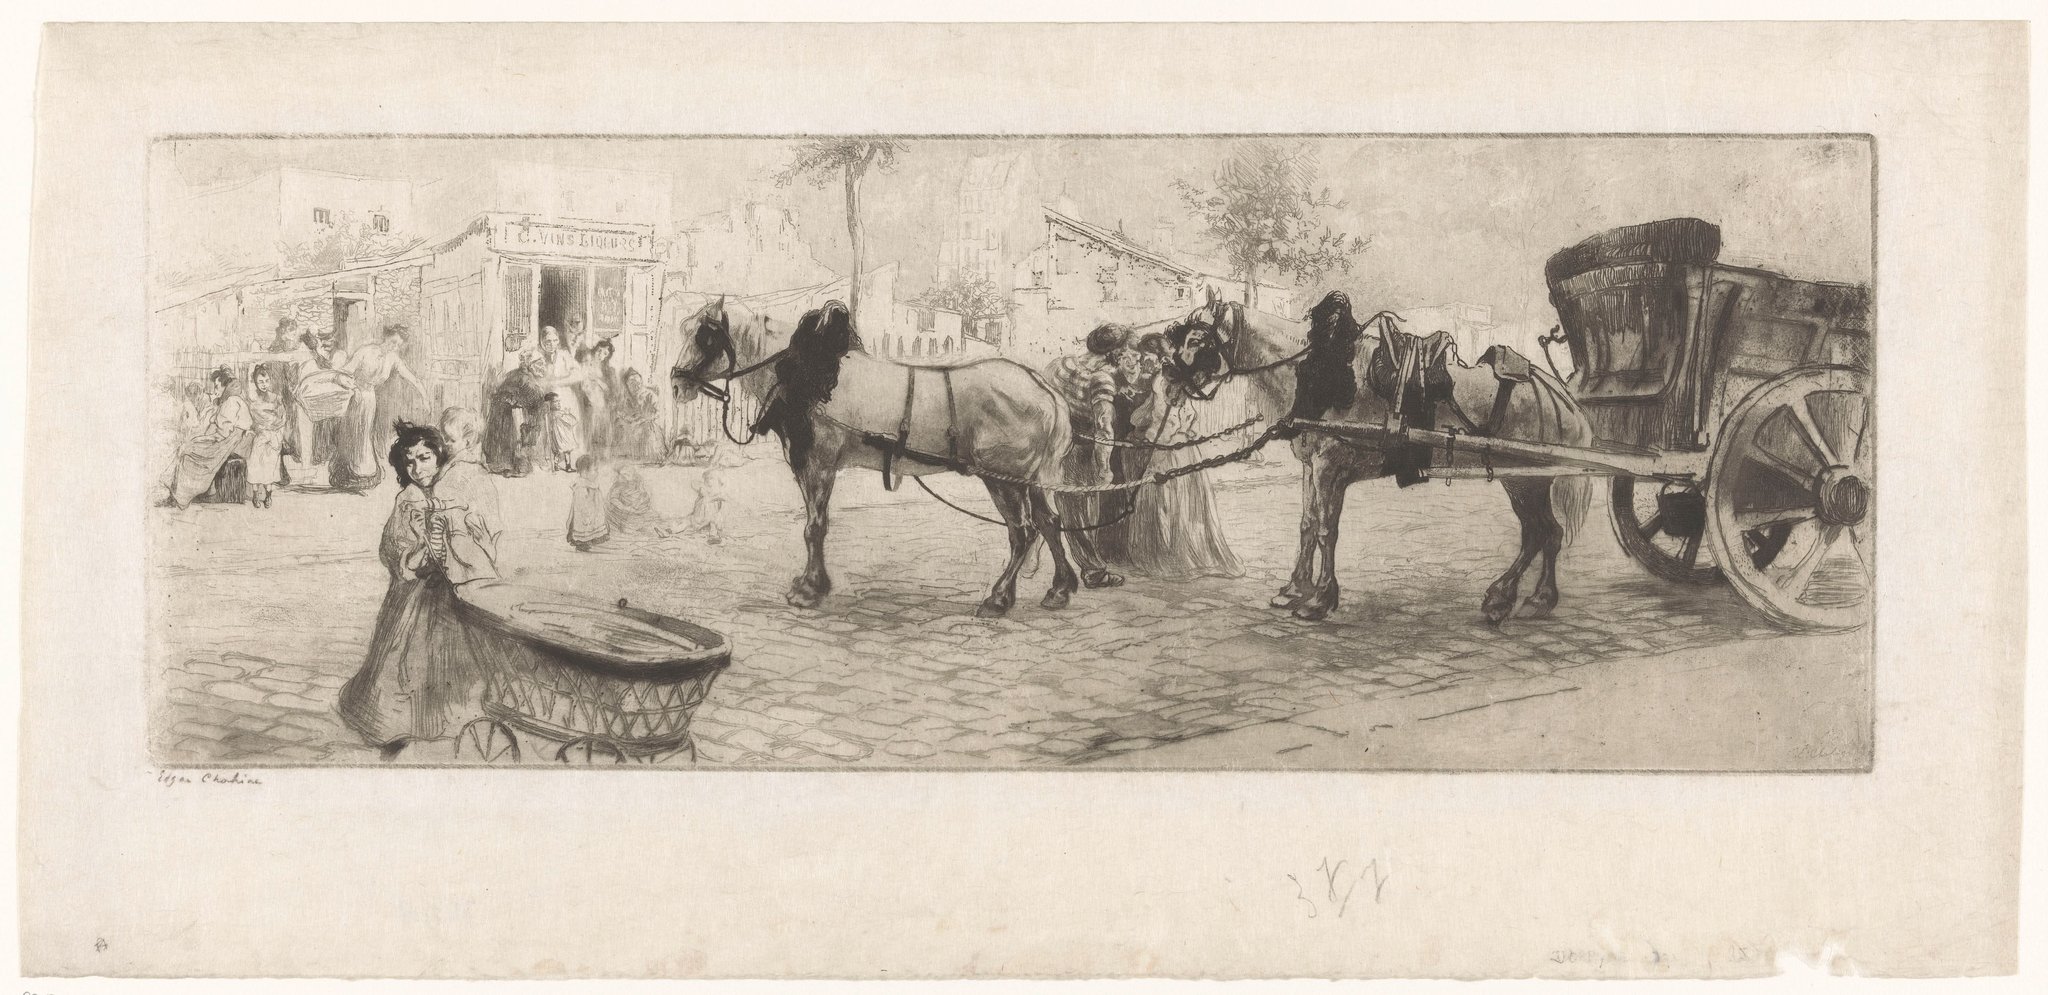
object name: print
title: Gezicht op een boulevard met voor een kar gespannen paarden en een vrouw met een kinderwagen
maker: edgar chahine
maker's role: print maker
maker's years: 1874-1947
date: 1884-1947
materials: paper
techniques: drypoint, etching, intaglio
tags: baby-carriage, pram, perambulator, horse, avenue, boulevard, promenade, esplanade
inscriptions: collector's mark: Lugt 2760, collector's mark: Lugt 2228